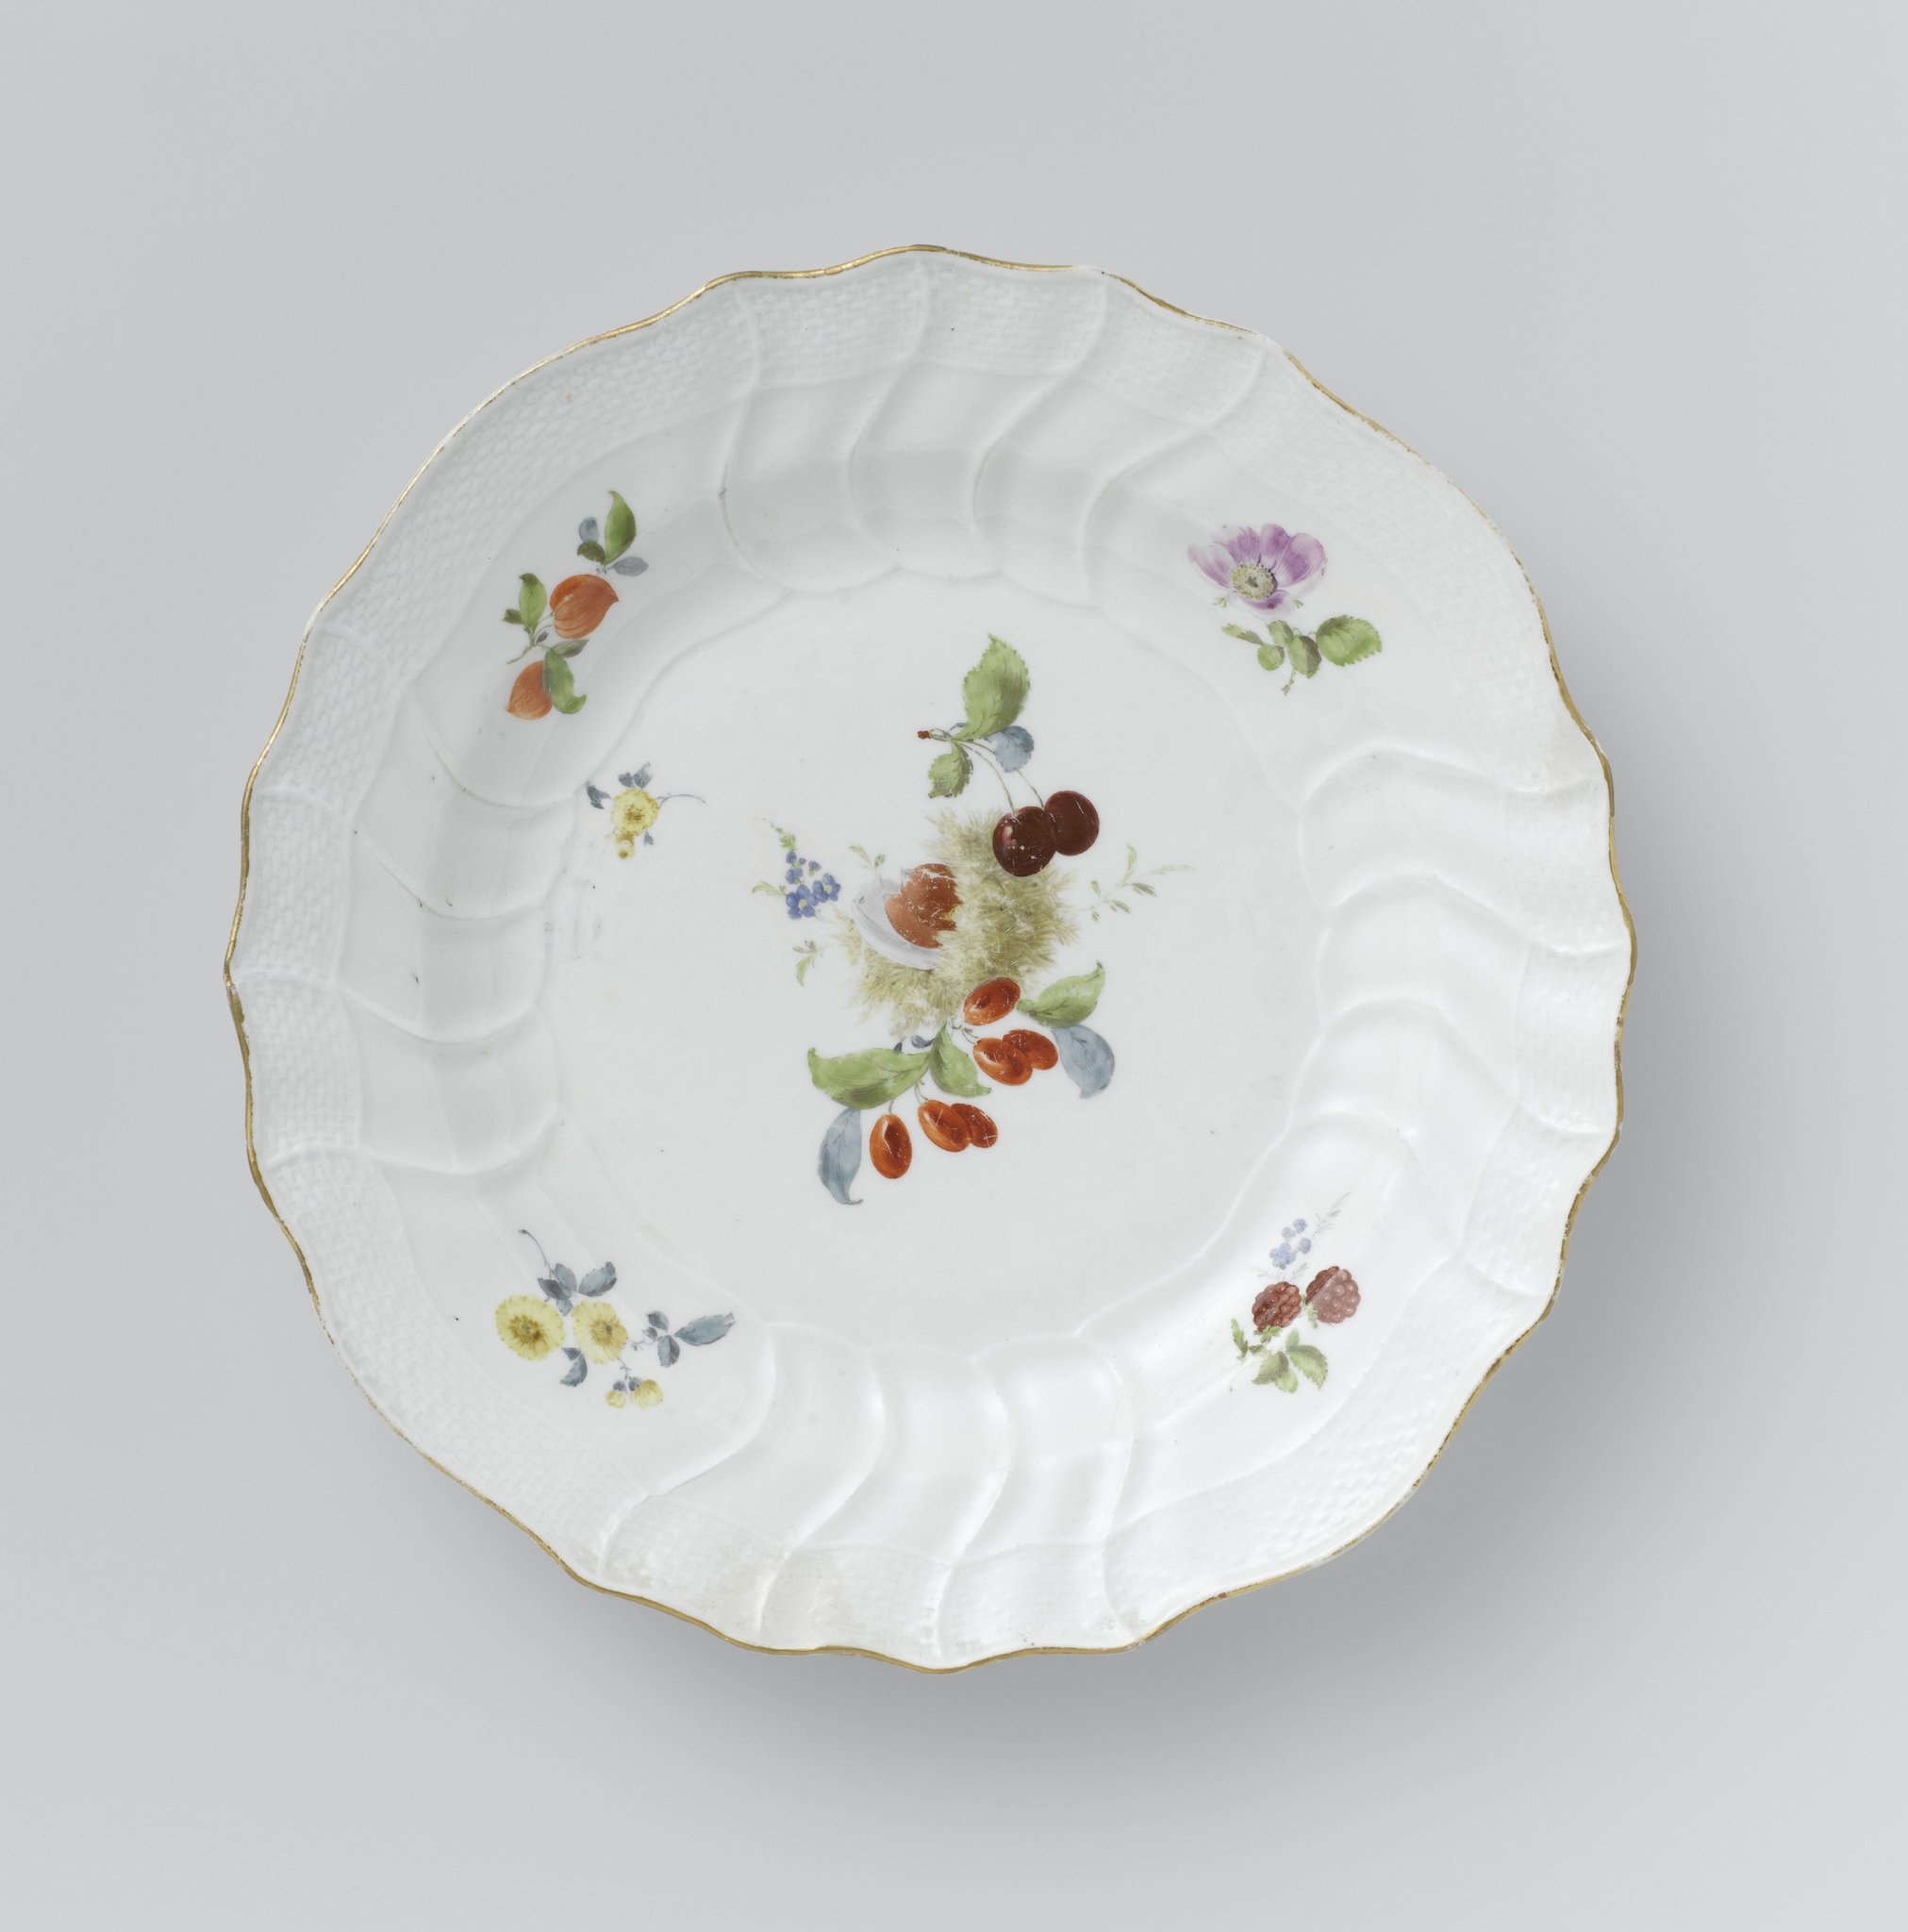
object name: plate dish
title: Bord, veelkleurig beschilderd met Deutsche Blumen, insekten en vruchten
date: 1750-1760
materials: porcelain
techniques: painted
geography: meissen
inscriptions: factory mark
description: Rond bord van beschilderd porselein. De rand is versierd met het Neuozier-patroon in reliëf. De beschildering bestaat uit Deutsche Blumen, insekten en vruchten. Het bord is gemerkt en hoort bij een servies (BK-17474-1 t/m BK-17474-253).